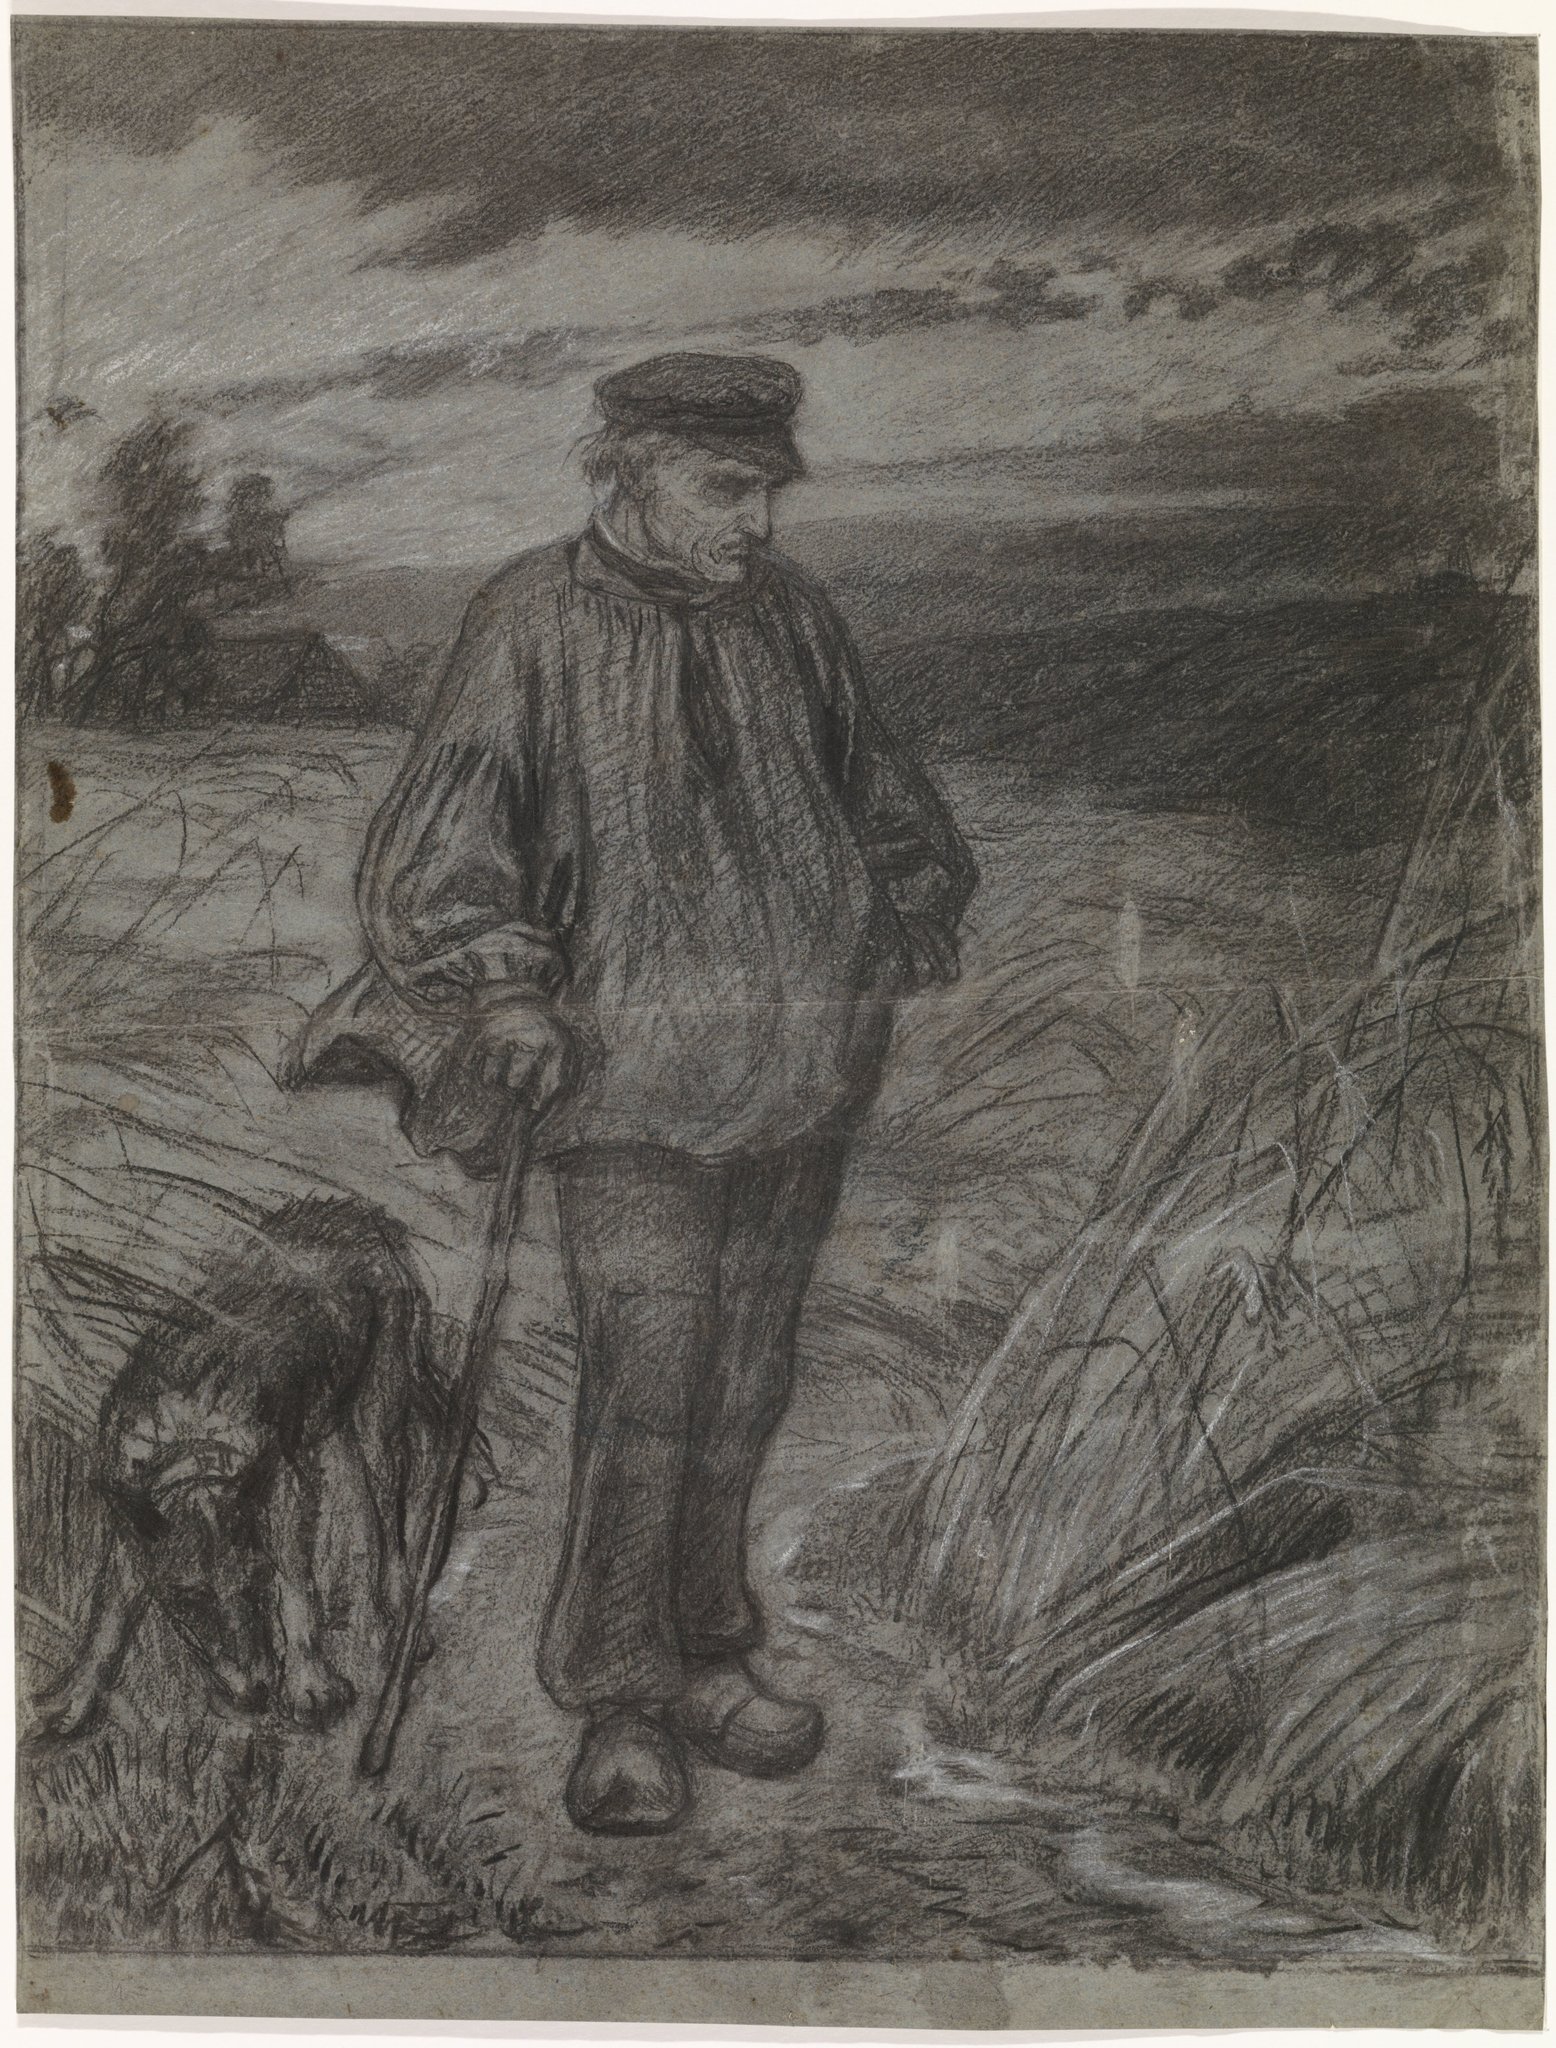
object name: drawing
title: Staande boer, de handen ineen geslagen, en zijn hond op de akker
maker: thomas simon cool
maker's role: draughtsman, print maker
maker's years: 1831-1870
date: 1841-1870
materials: chalk, paper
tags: dog